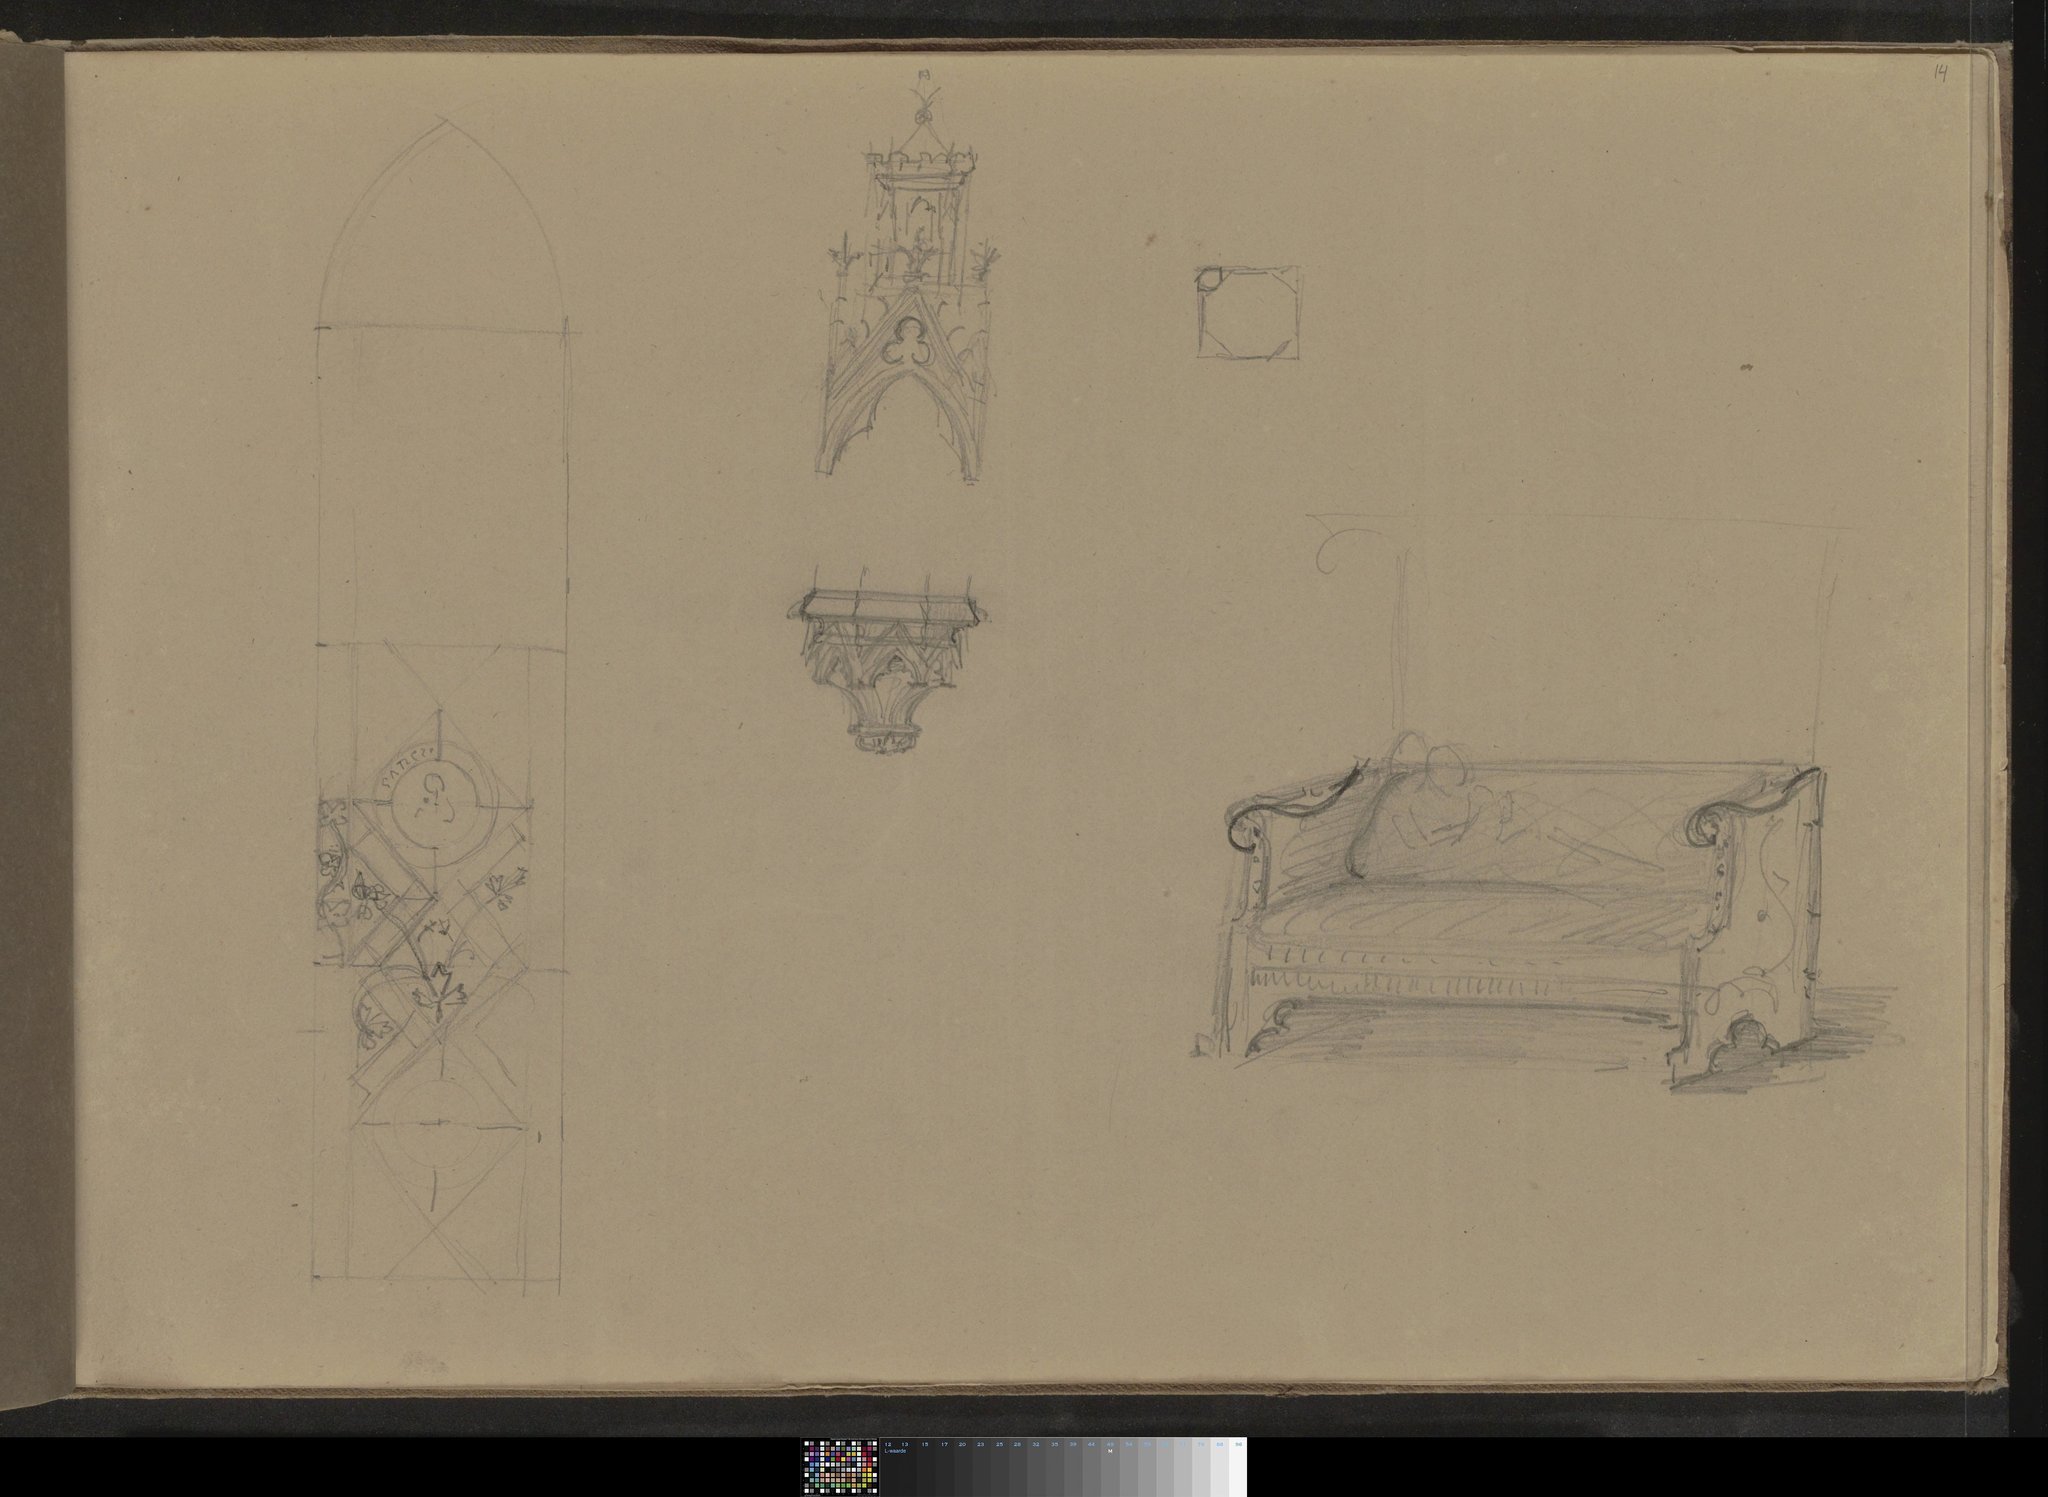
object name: sketchbook leaf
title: Koorbank, ornamenten en een ontwerp voor een glas-in-loodvenster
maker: pierre joseph hubert cuypers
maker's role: draughtsman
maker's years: 1827-1921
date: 1837-1921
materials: paper, pencil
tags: liturgical furniture, etc., architectural detail, work of applied art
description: Blad 14 recto uit een schetsboek met 23 bladen.